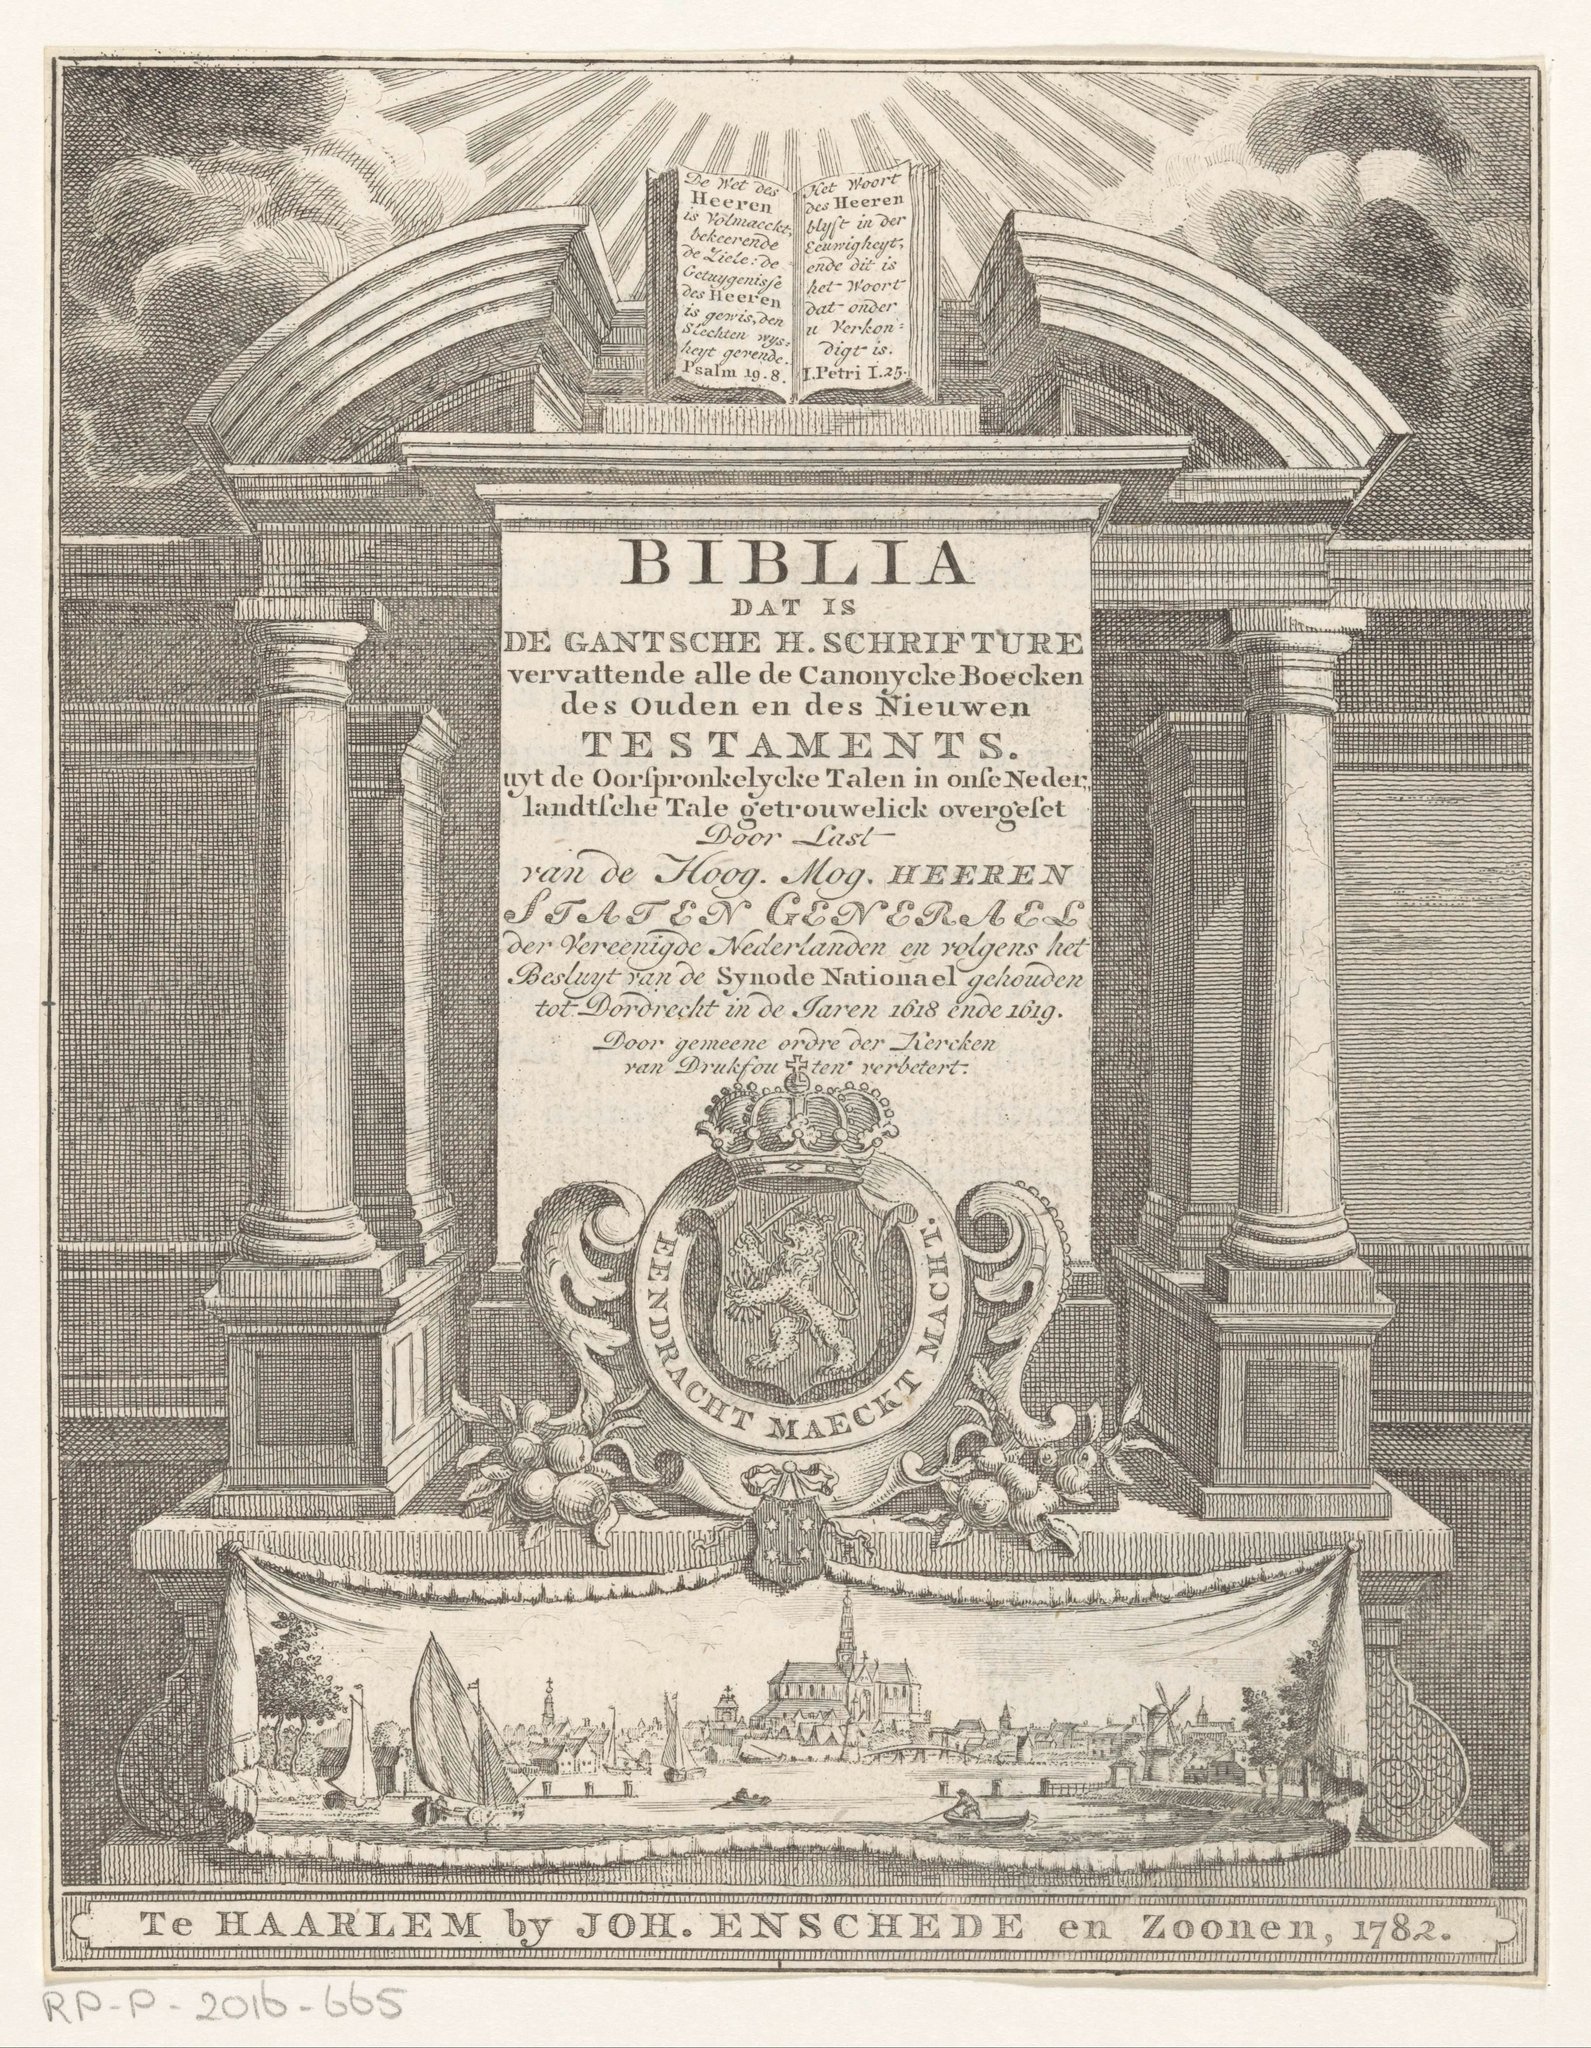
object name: titelblad, titelpagina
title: Architecturale setting en gezicht op stad aan water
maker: Anonymous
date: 1782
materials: paper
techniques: engraving, etching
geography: haarlem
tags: city-view in general; 'veduta', architecture, dutch republic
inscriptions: collector's mark: Lugt 2228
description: Een architecturale setting met zuilen en in het midden de titel. In het midden het wapenschild van de Republiek der Zeven Verenigde Nederlanden met spreuk Eendracht maeckt macht. Daaronder een gezicht op een stad aan het water.